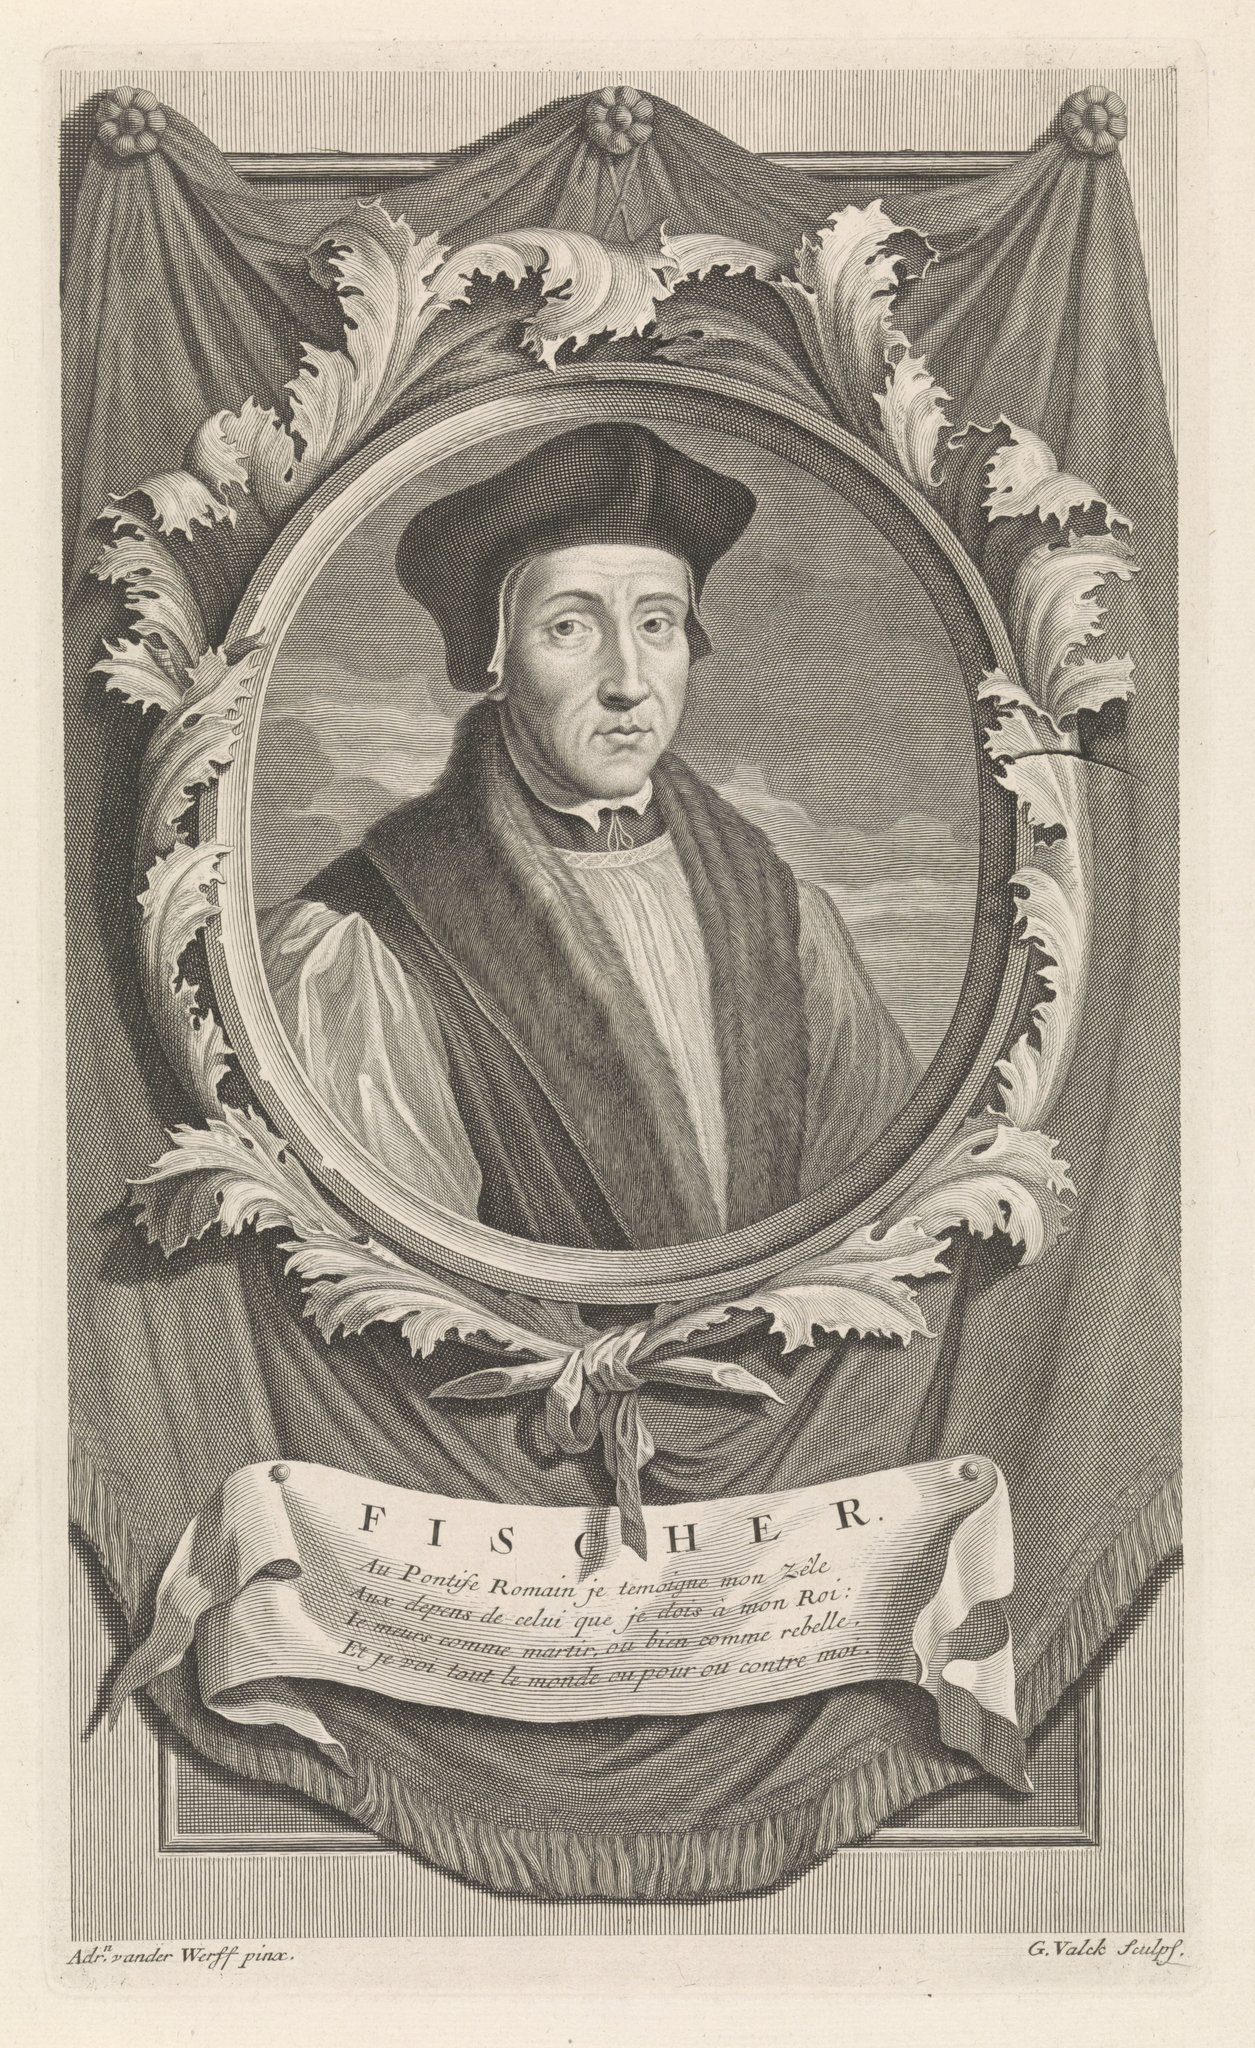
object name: print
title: Zeven portretten van historische figuren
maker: adriaen van der werff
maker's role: draughtsman, painter, print maker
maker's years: 1659-1722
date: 1697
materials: paper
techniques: engraving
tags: london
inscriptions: collector's mark: Lugt 2228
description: Prent ook gebruikt als boekillustratie in: Larrey, Isaac de. Histoire d'Angleterre, d'Ecosse, et d'Irlande. Rotterdam: Reinier Leers, 1697.